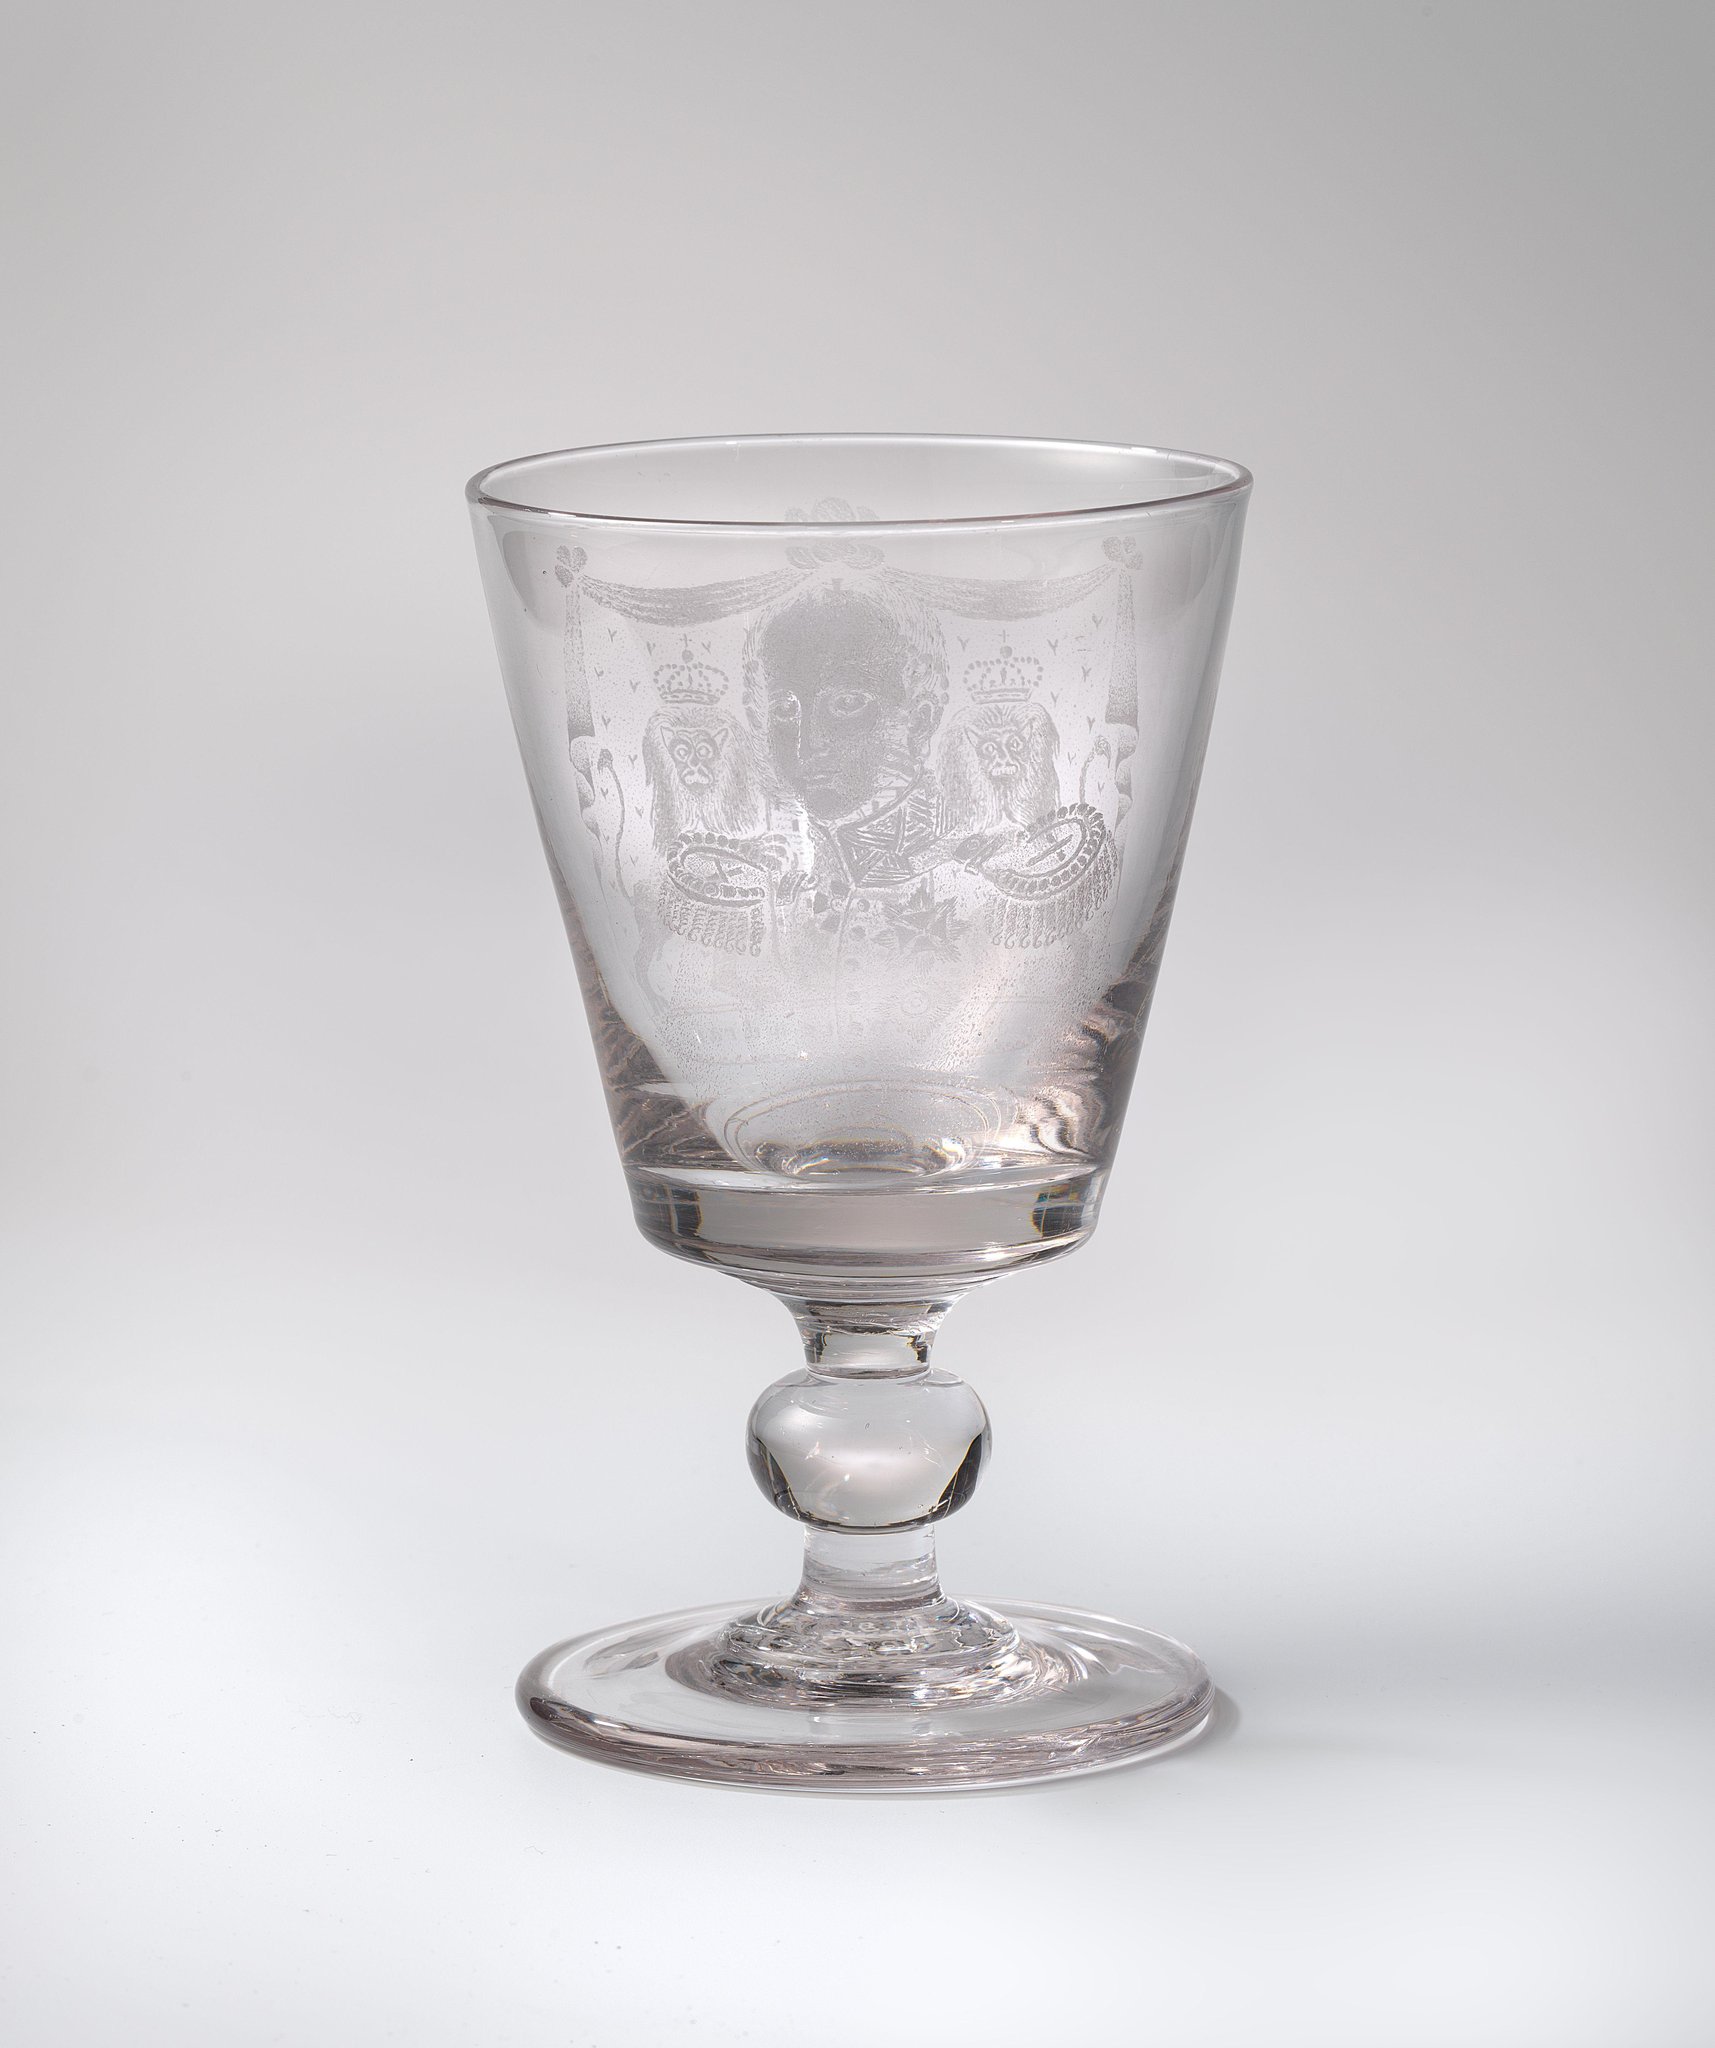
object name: goblet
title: Kelkglas met een portret van Willem II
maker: nicolaas ludolf hoevenaar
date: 1847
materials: glass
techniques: glassblowing, engraving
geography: netherlands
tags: the hague, william ii of the netherlands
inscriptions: signature: ‘N L Hoevenaar 1847’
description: Platte voet. Stam met massieve, bolvormige knoop. Conische kelk met afgeplatte onderzijde. Op de kelk een portret ten halven lijve van koning Willem II in militair tenue. Op de keerzijde, onder een baldakijn, het gekroonde wapen van Nederland, opgehouden door twee gekroonde leeuwen. Onder het wapen het motto: je maintiendrai. Gesigneerd op de voet: N L Hoevenaar 1847.